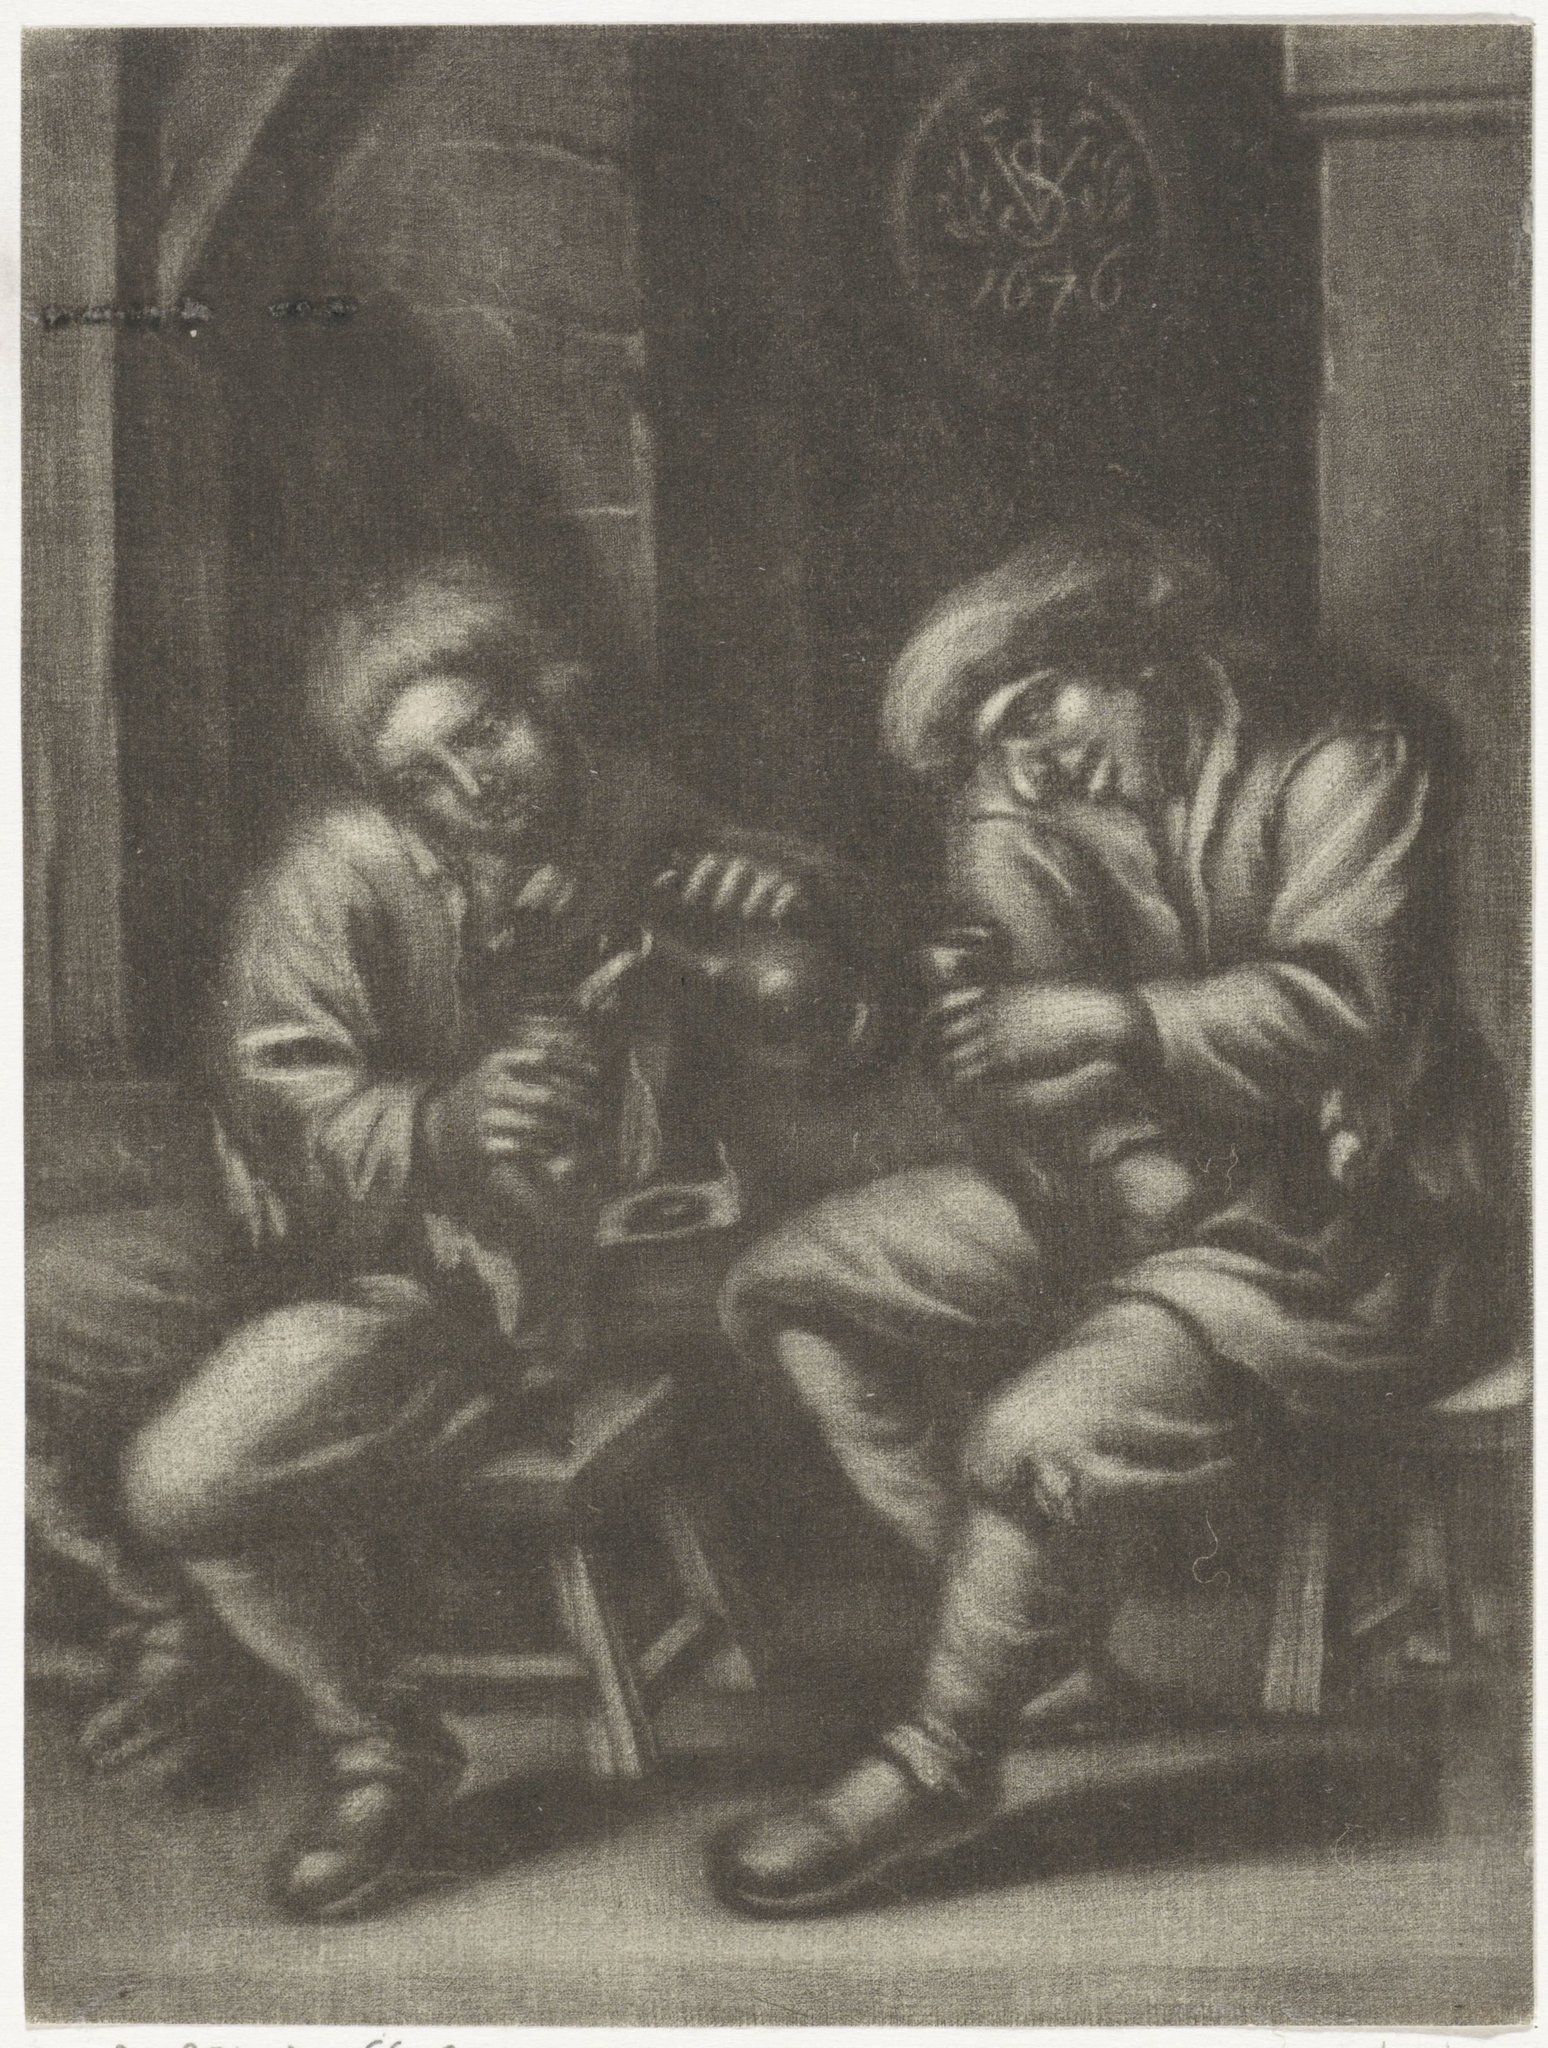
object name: print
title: Drinkende mannen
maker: jan van somer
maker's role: draughtsman, print maker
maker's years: 1645-1699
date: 1676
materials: paper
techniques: mezzotint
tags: pouring, farmers, drinking, glass of beer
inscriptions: collector's mark: Lugt 2228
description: Twee mannen zitten met elkaar te drinken. Een van de mannen schenkt zichzelf bier in terwijl de andere zijn glas al paraat houdt.